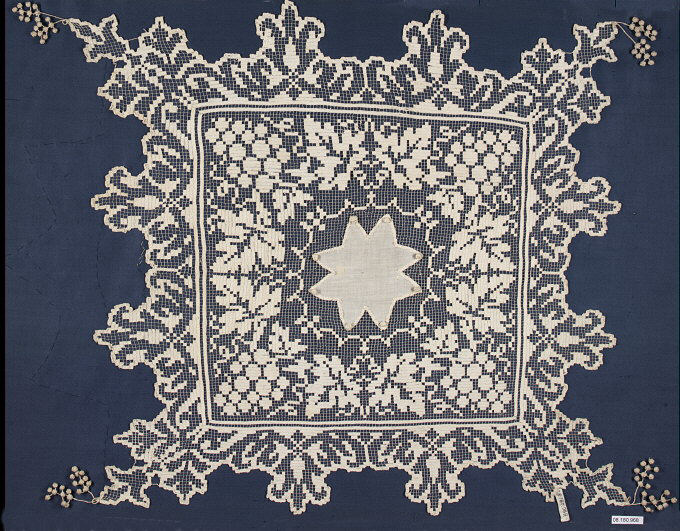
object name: mat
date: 1801-1900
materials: linen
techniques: embroidery